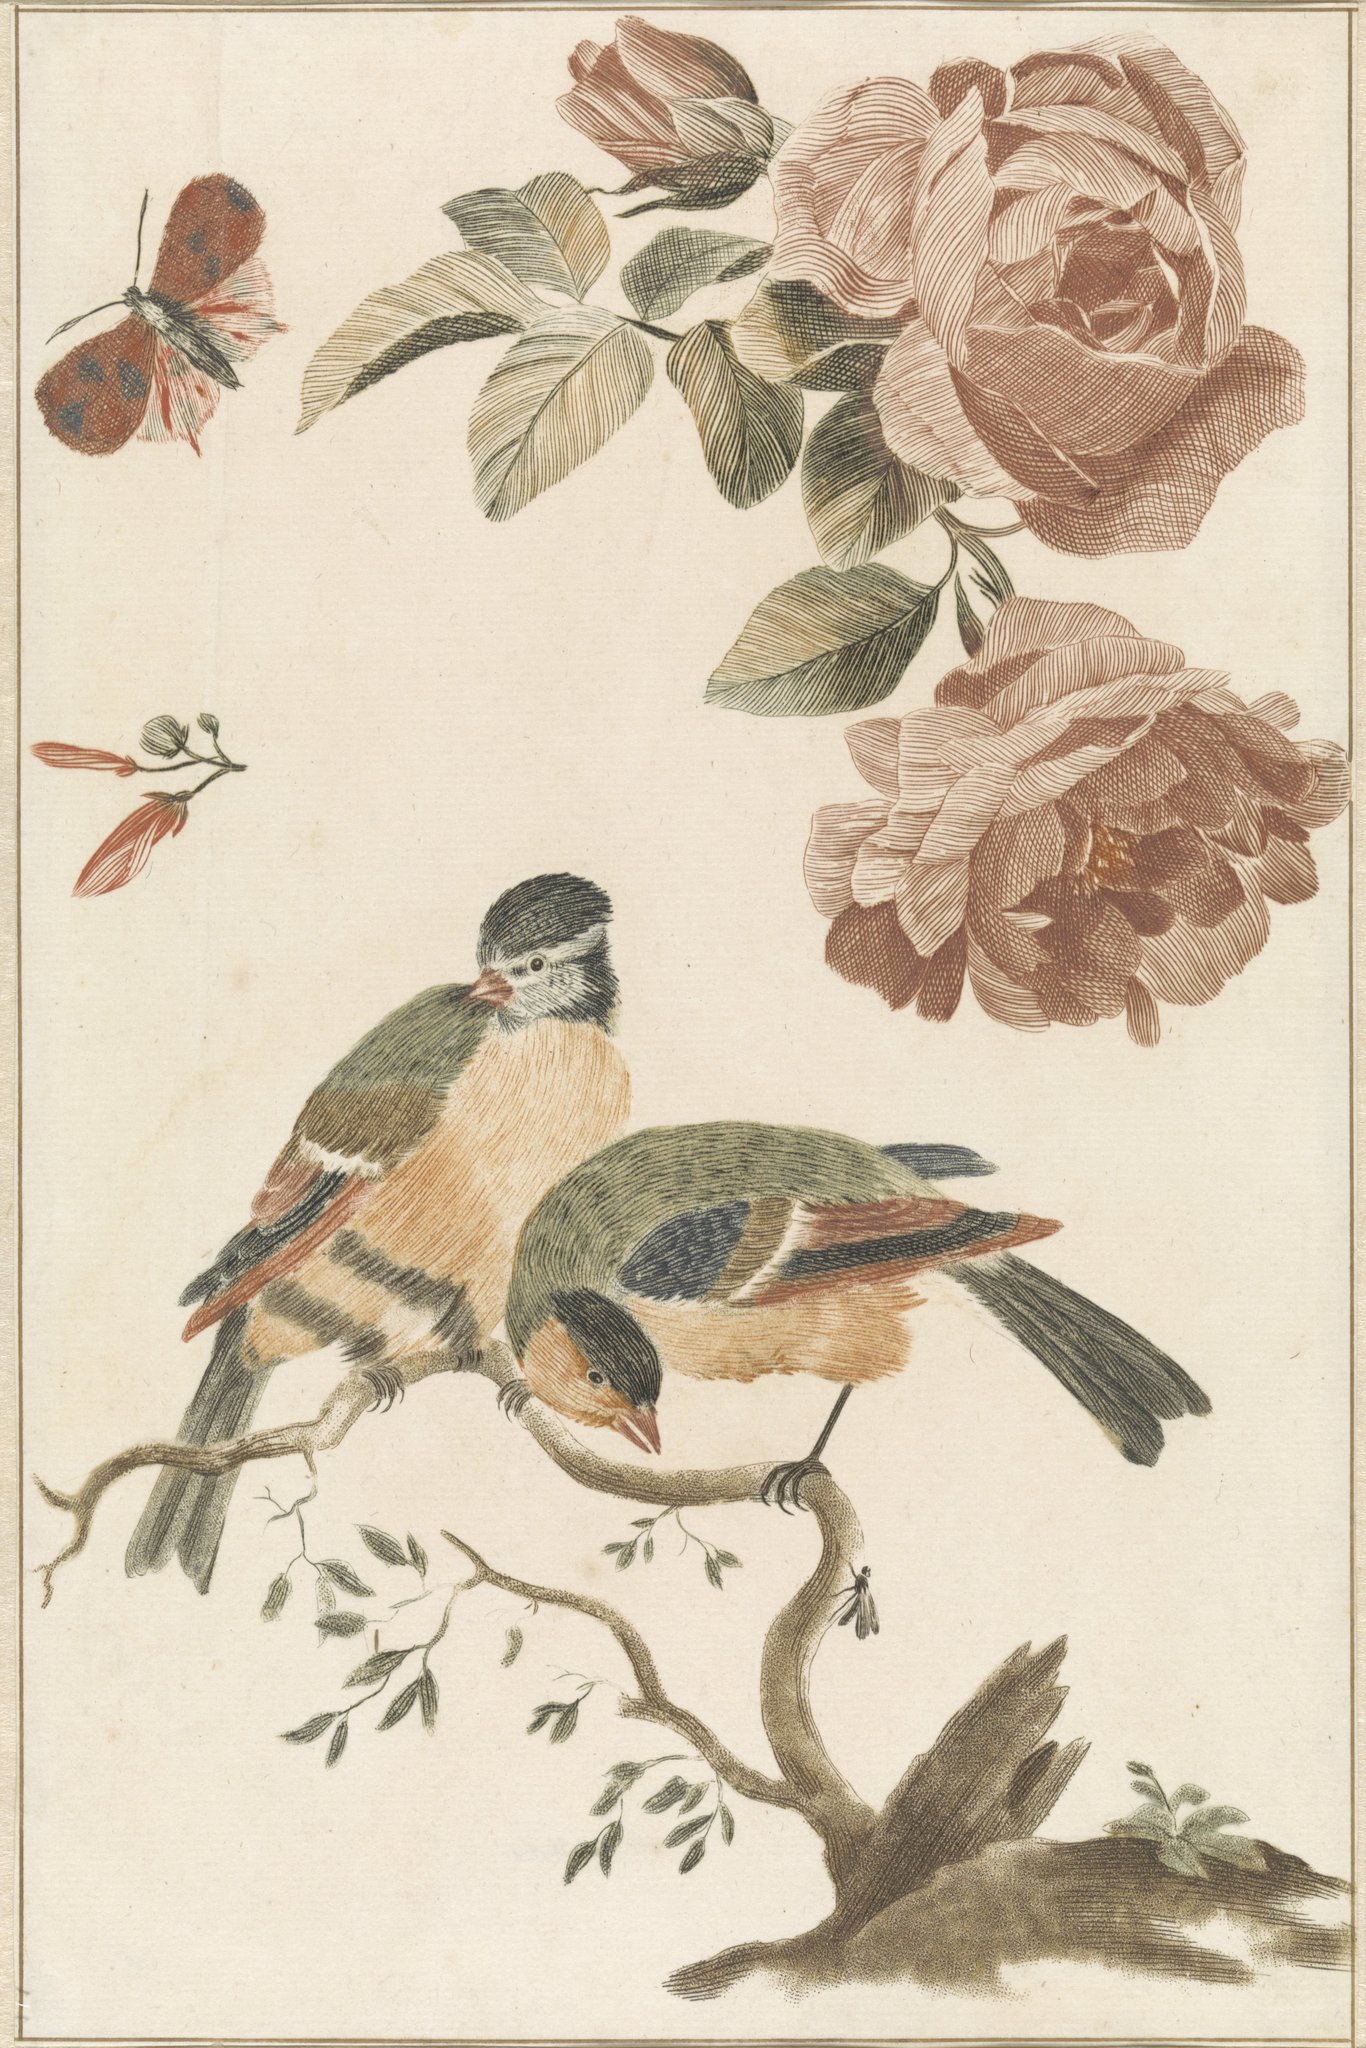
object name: print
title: Een pimpelmees en een koolmees op een tak, twee rozen en een vlinder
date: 1688-1698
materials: paper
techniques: printing, engraving, rocker stamped, lithography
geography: netherlands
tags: song-birds, insects: butterfly, flowers: rose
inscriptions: collector's mark: Lugt 2228